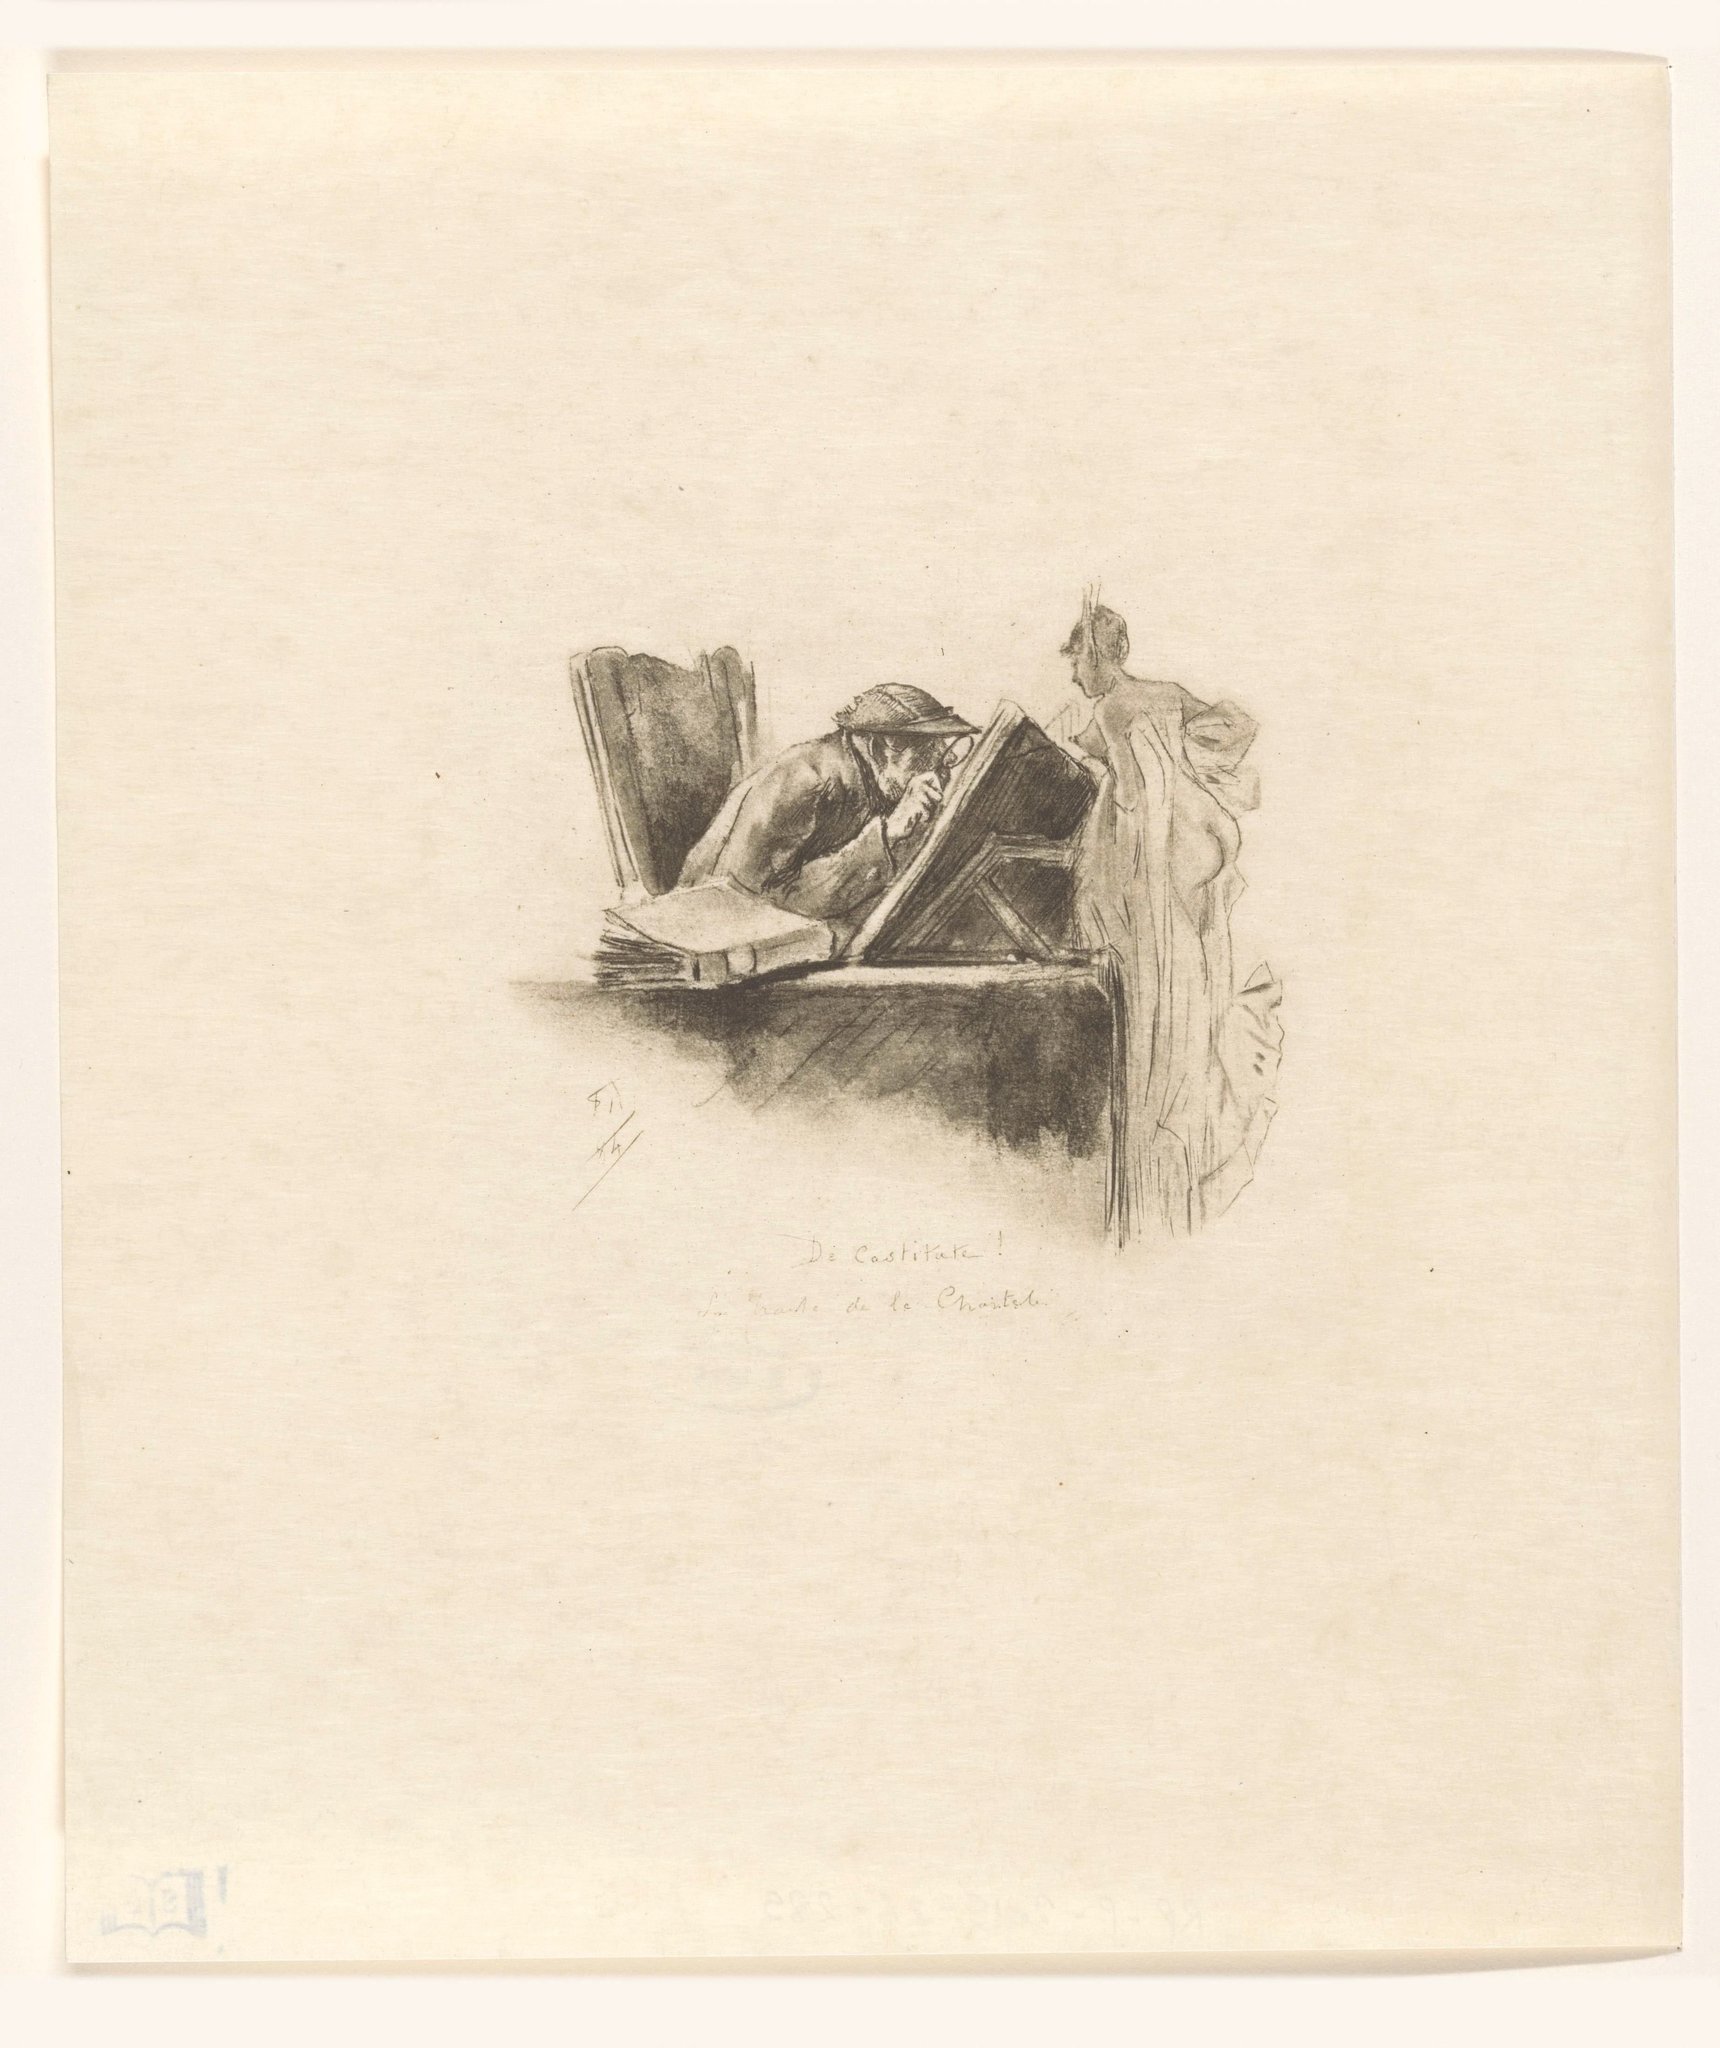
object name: print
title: Kuisheid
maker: félicien rops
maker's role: draughtsman, print maker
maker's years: 1833-1898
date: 1884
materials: paper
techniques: photoaquatint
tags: chastity, woman (showing herself) undressed, quasi-nude, magnifying glass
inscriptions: collector's mark: Lugt 2228, collector's mark: Lugt 4780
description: Een man bekijkt een boek op een standaard met een loep en heeft geen oog voor de half ontklede vrouw op de achtergrond.